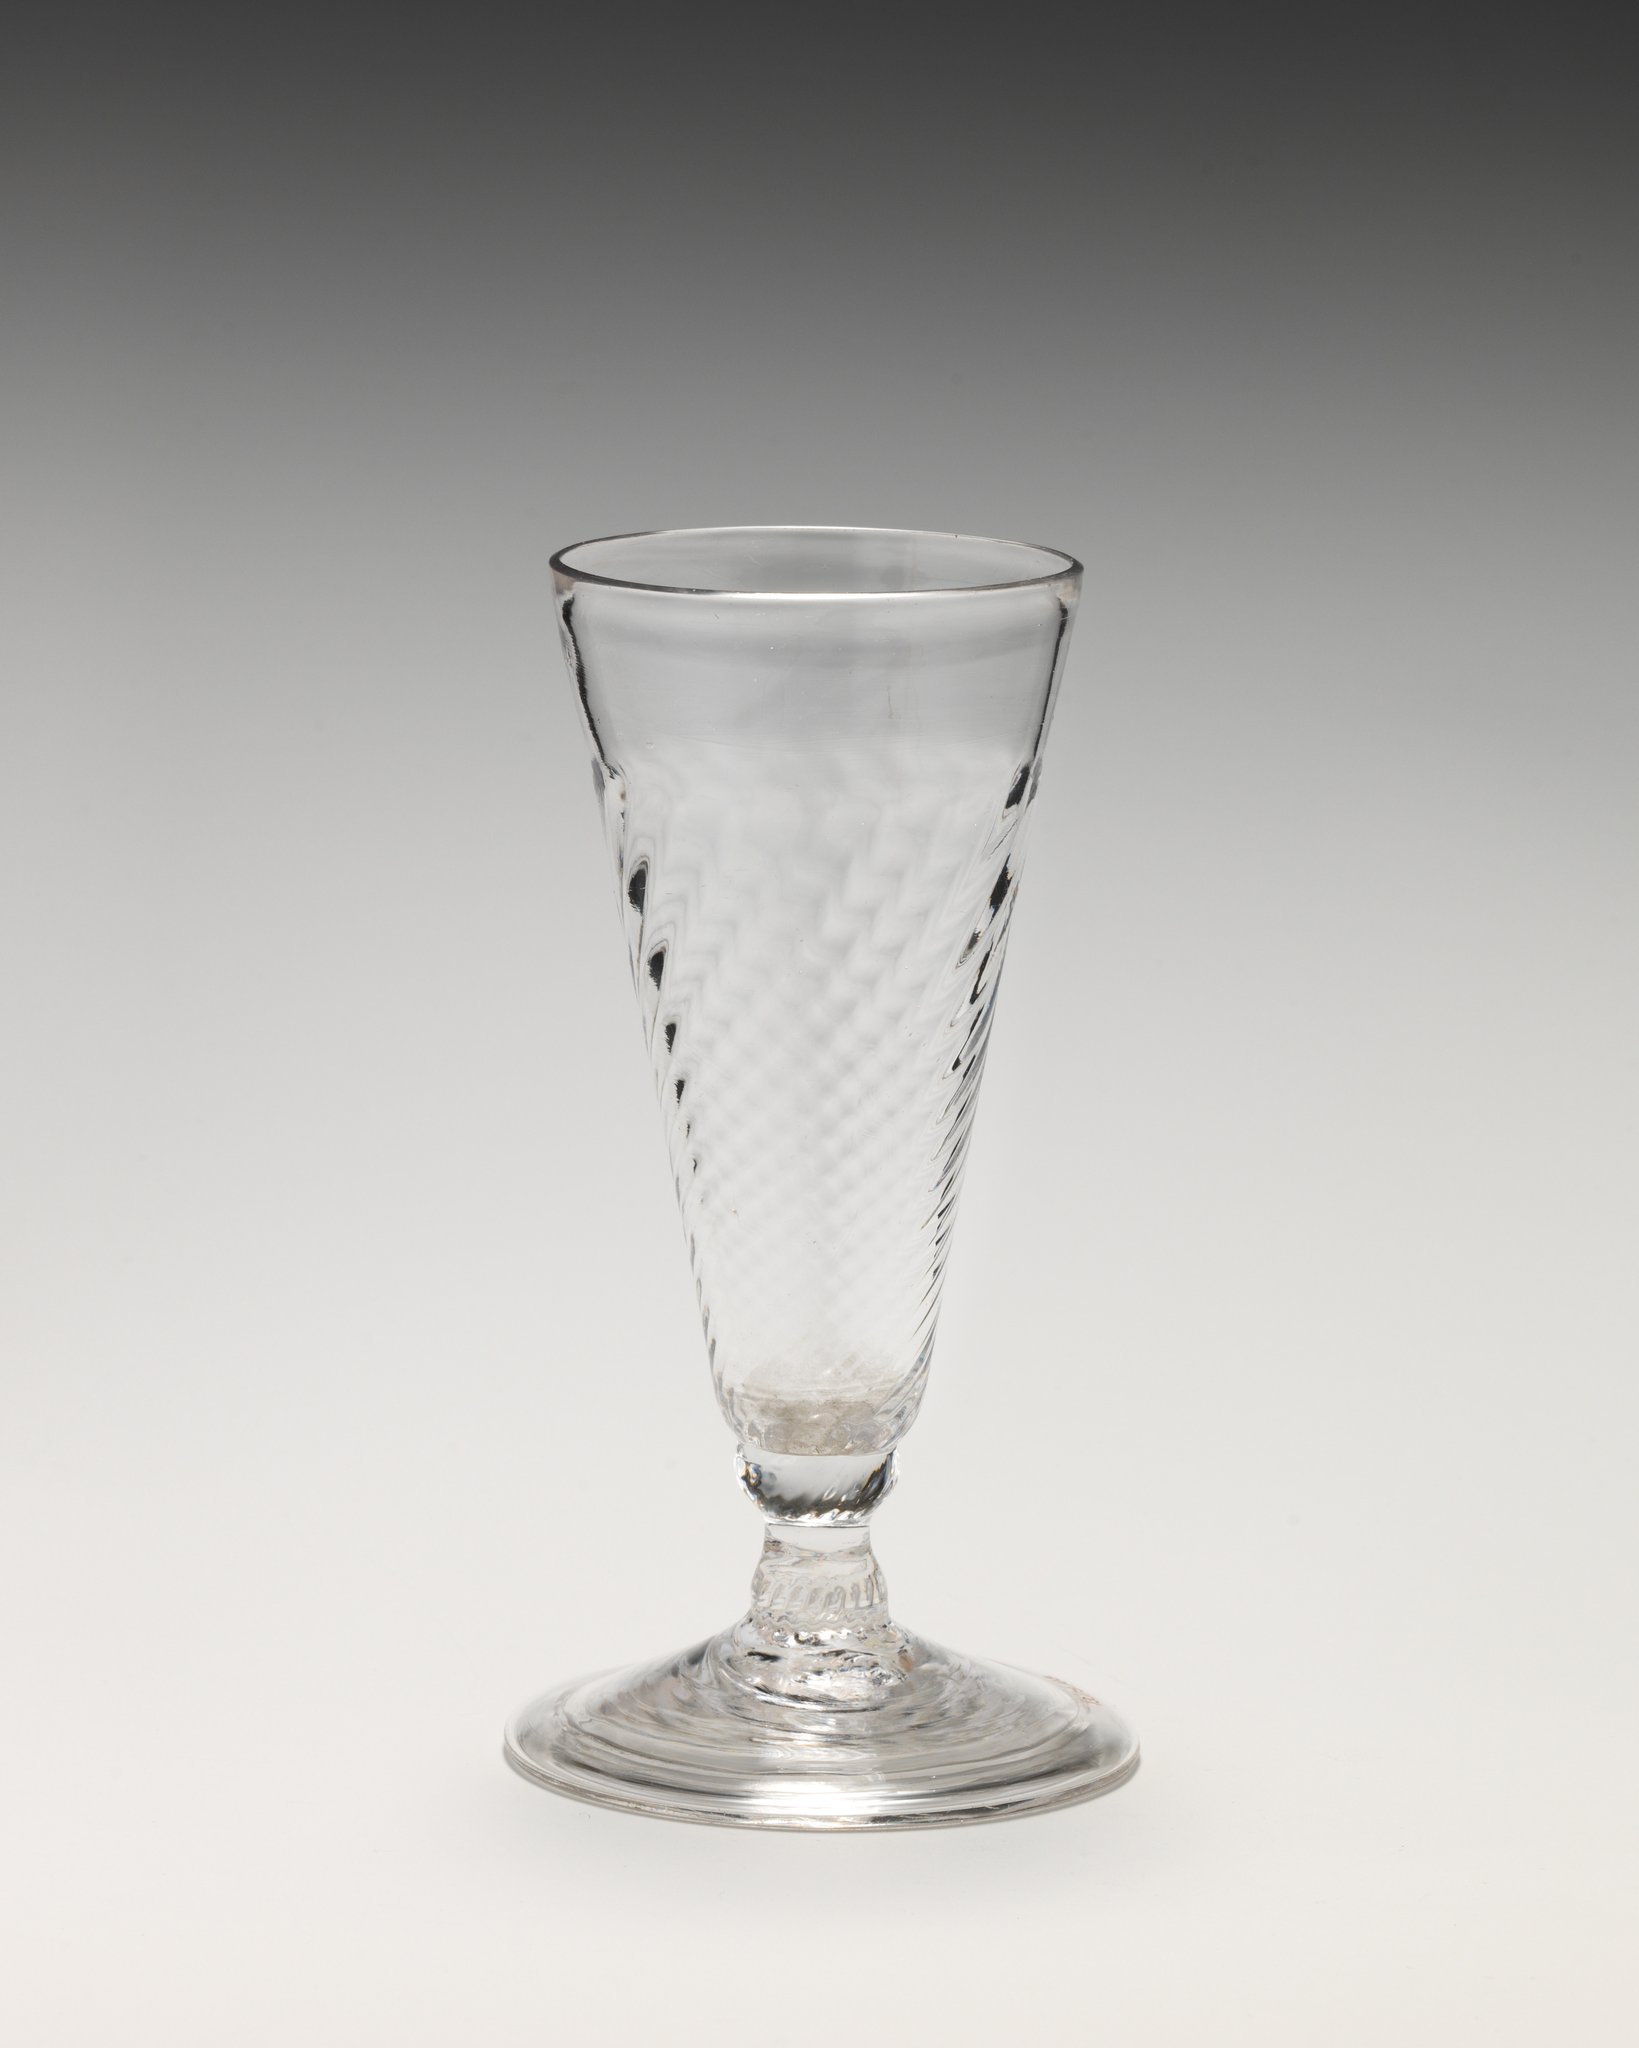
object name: ale glass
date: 1701-1750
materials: glass